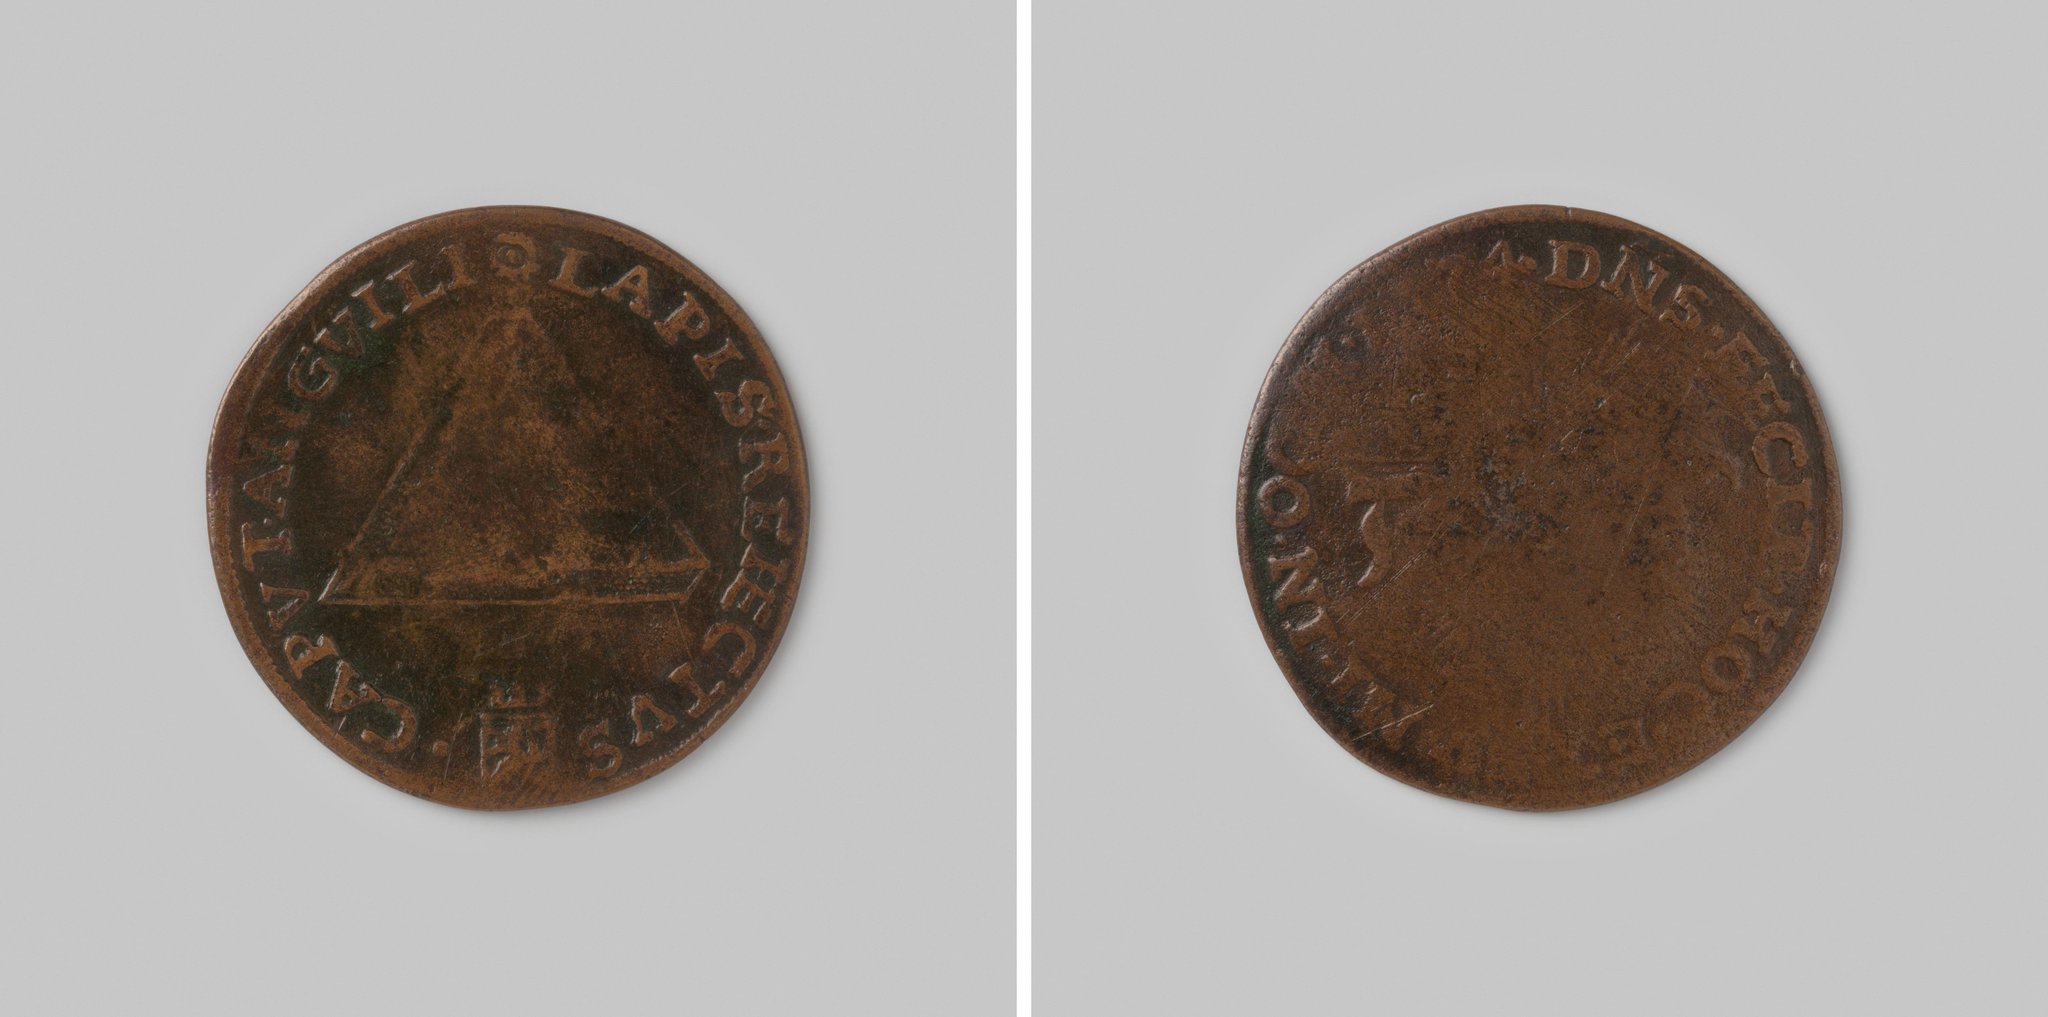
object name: history medal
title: Rekenpenning uit Dordrecht op de vrijheid van godsdienst 1574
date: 1574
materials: copper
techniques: striking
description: Koperen penning, op de voorzijde een driehoekige steen met omschrift, op de keerzijde het stralende woord Jehova in Hebreeuwse karakters, met omschrift.